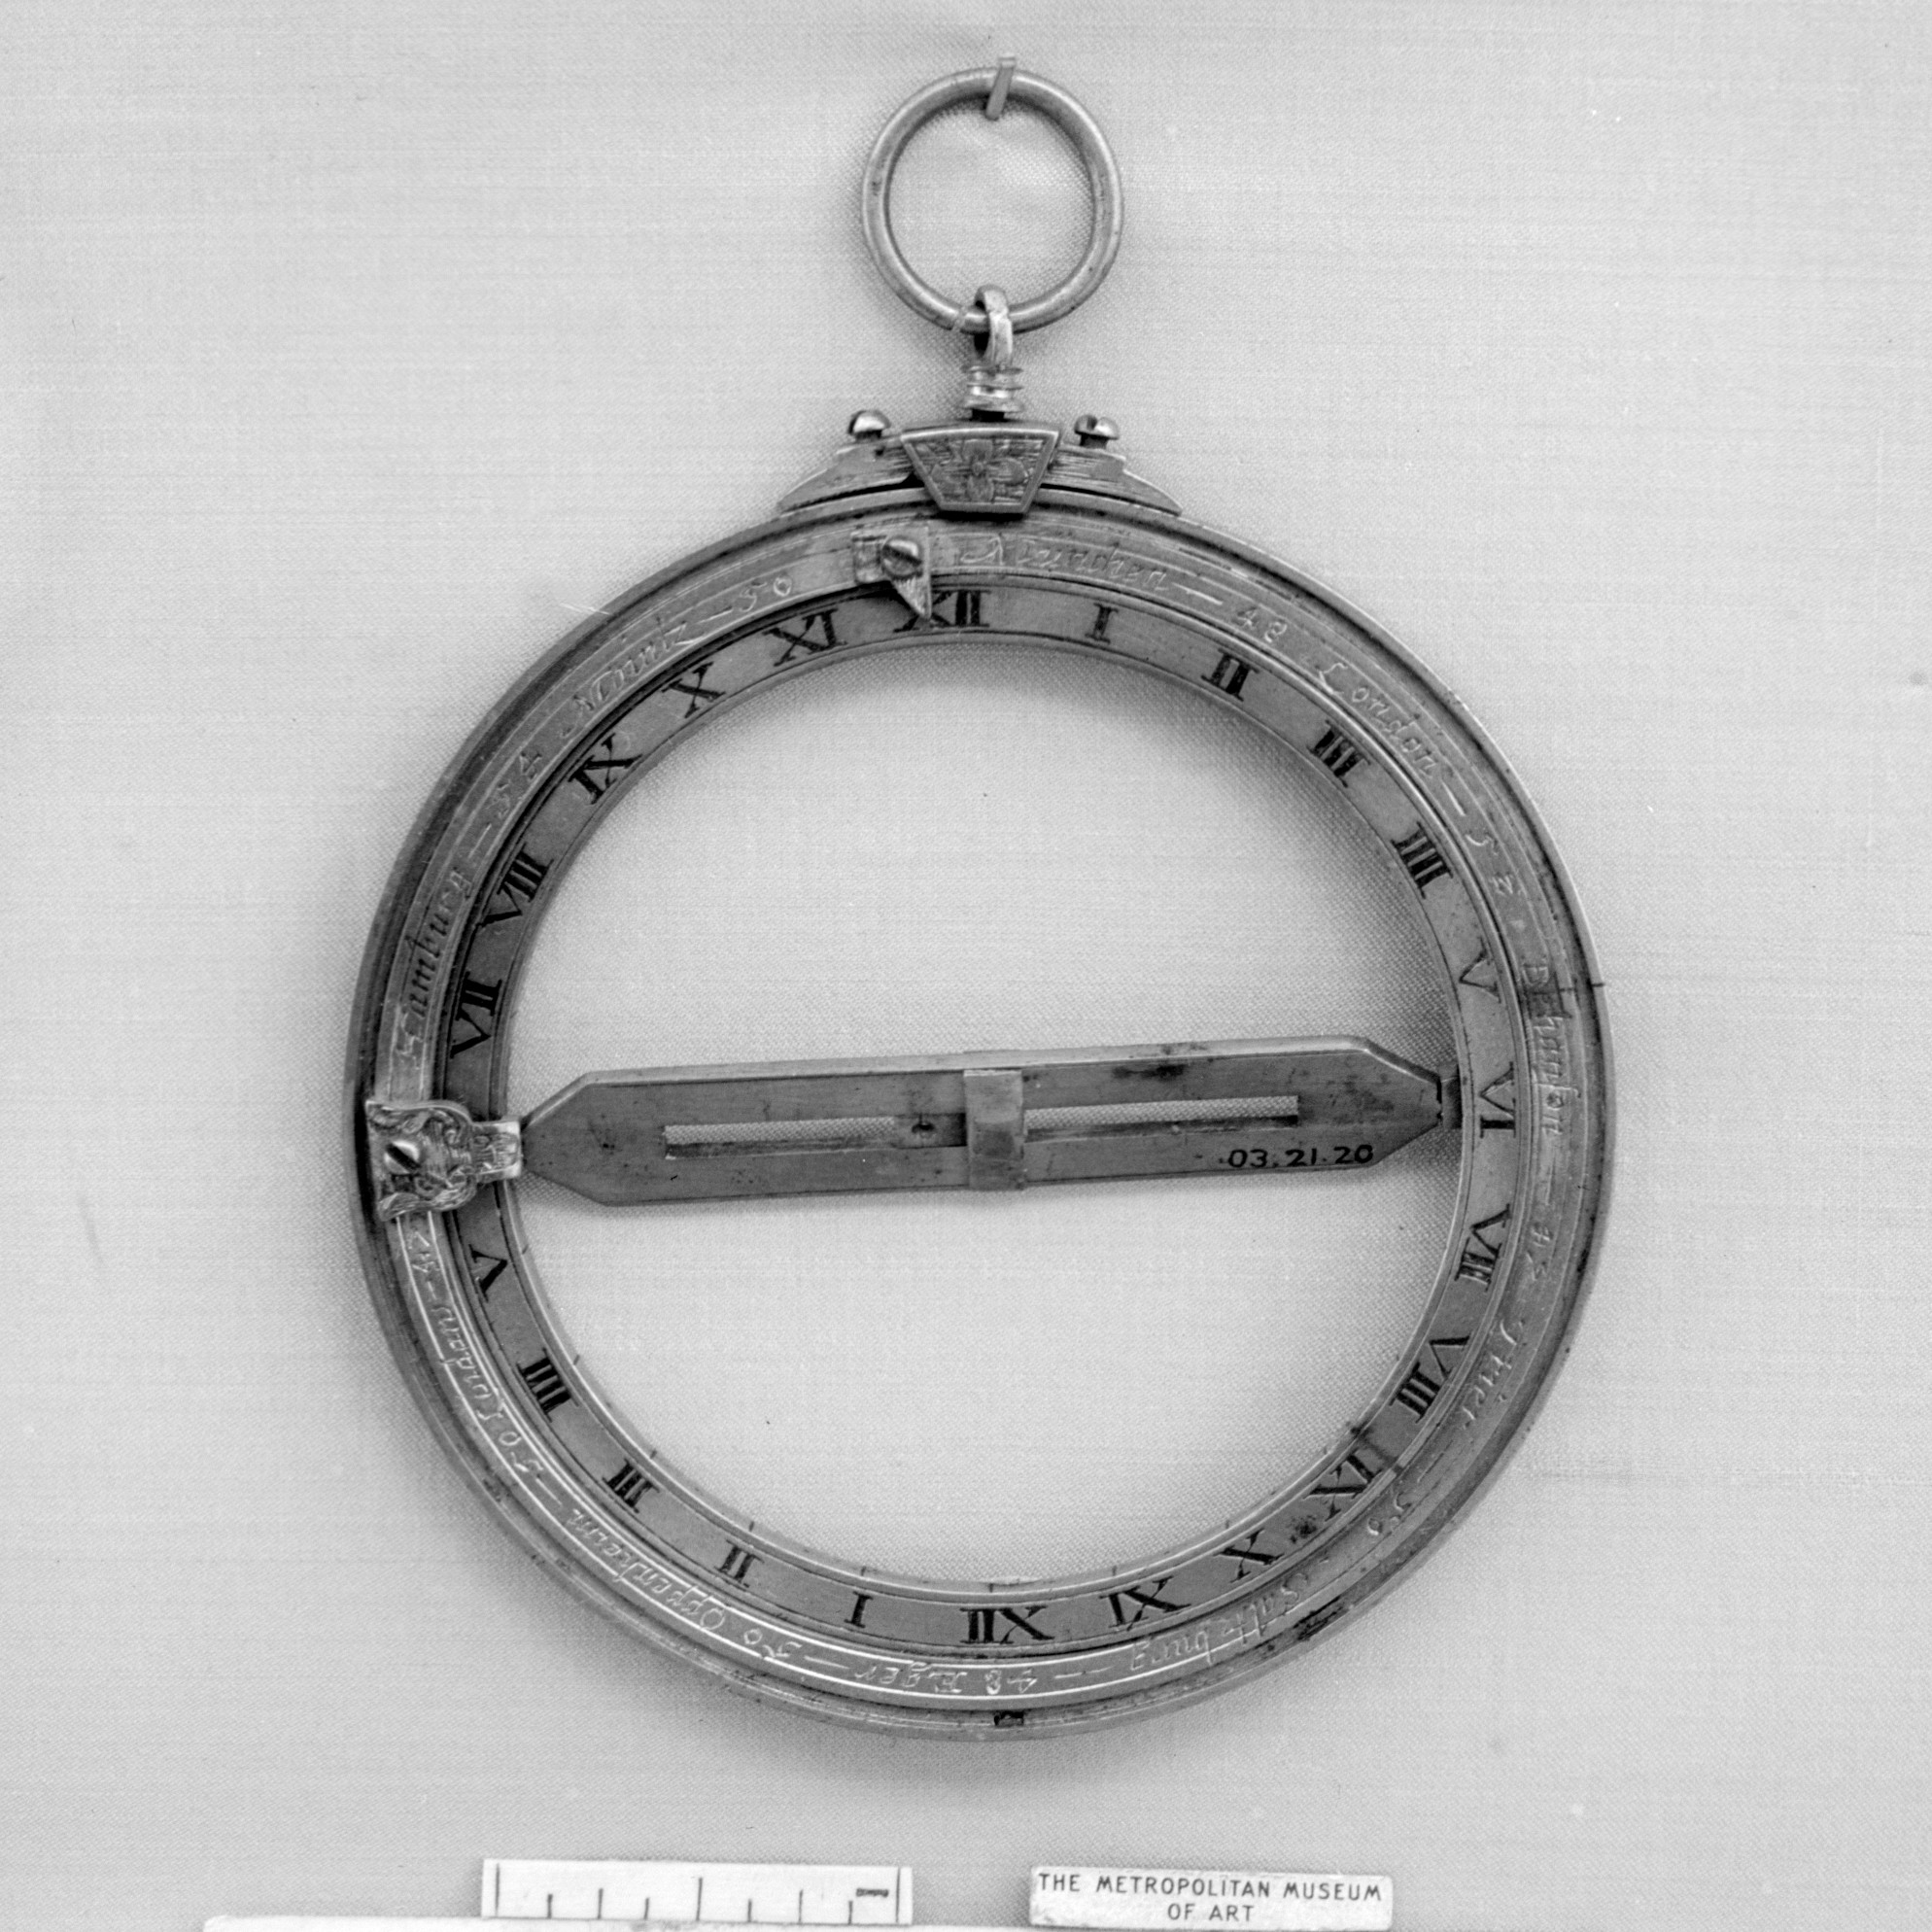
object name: universal ring sundial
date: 1701-1800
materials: gilt brass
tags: sundials